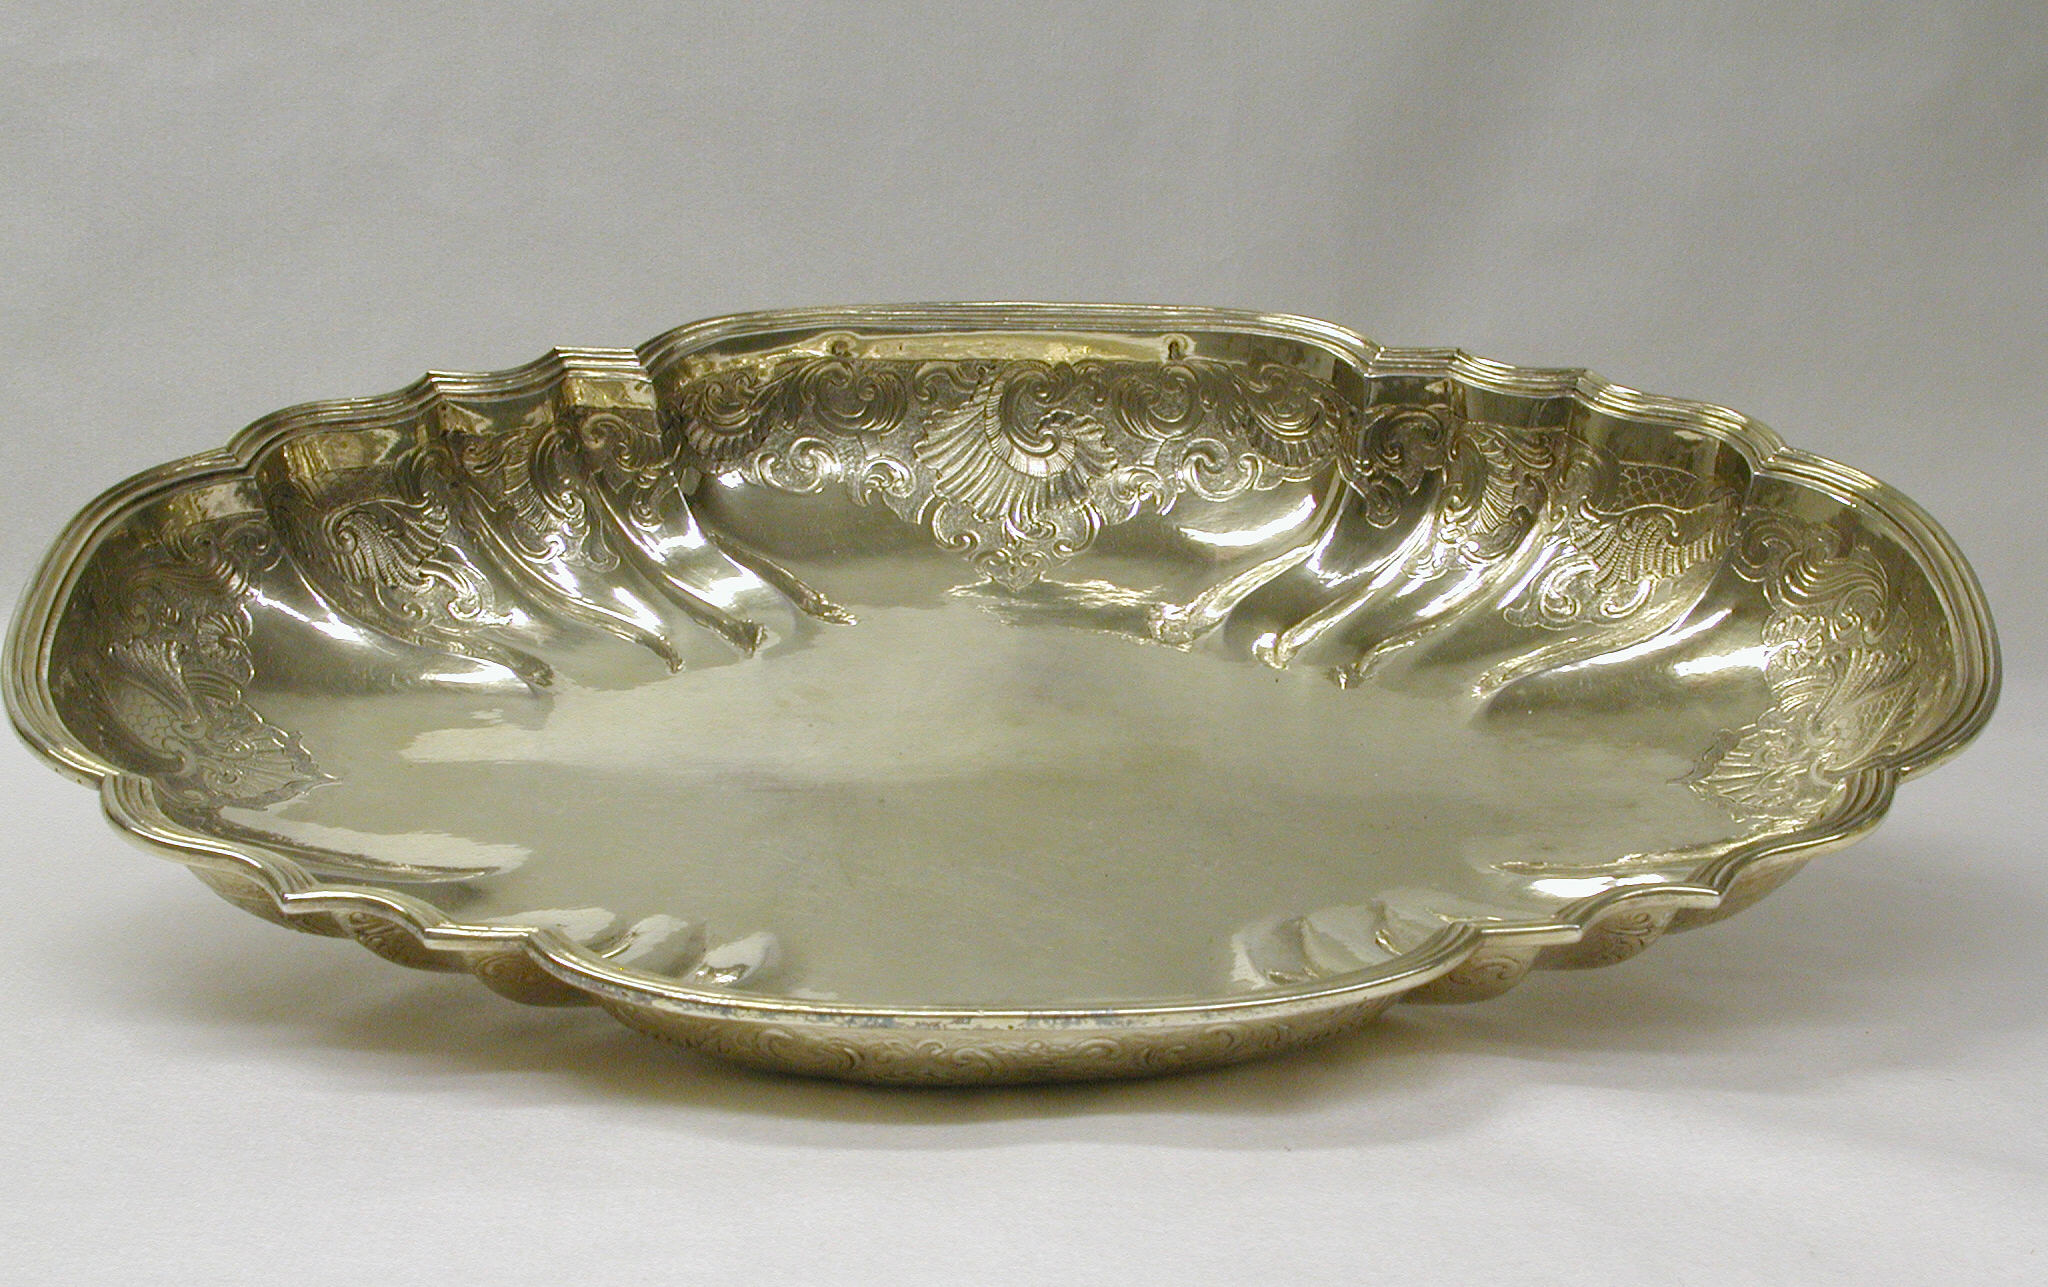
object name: basin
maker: friedrich schwestermuller ii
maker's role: maker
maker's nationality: german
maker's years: 1713-1752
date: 1743-1745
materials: silver gilt